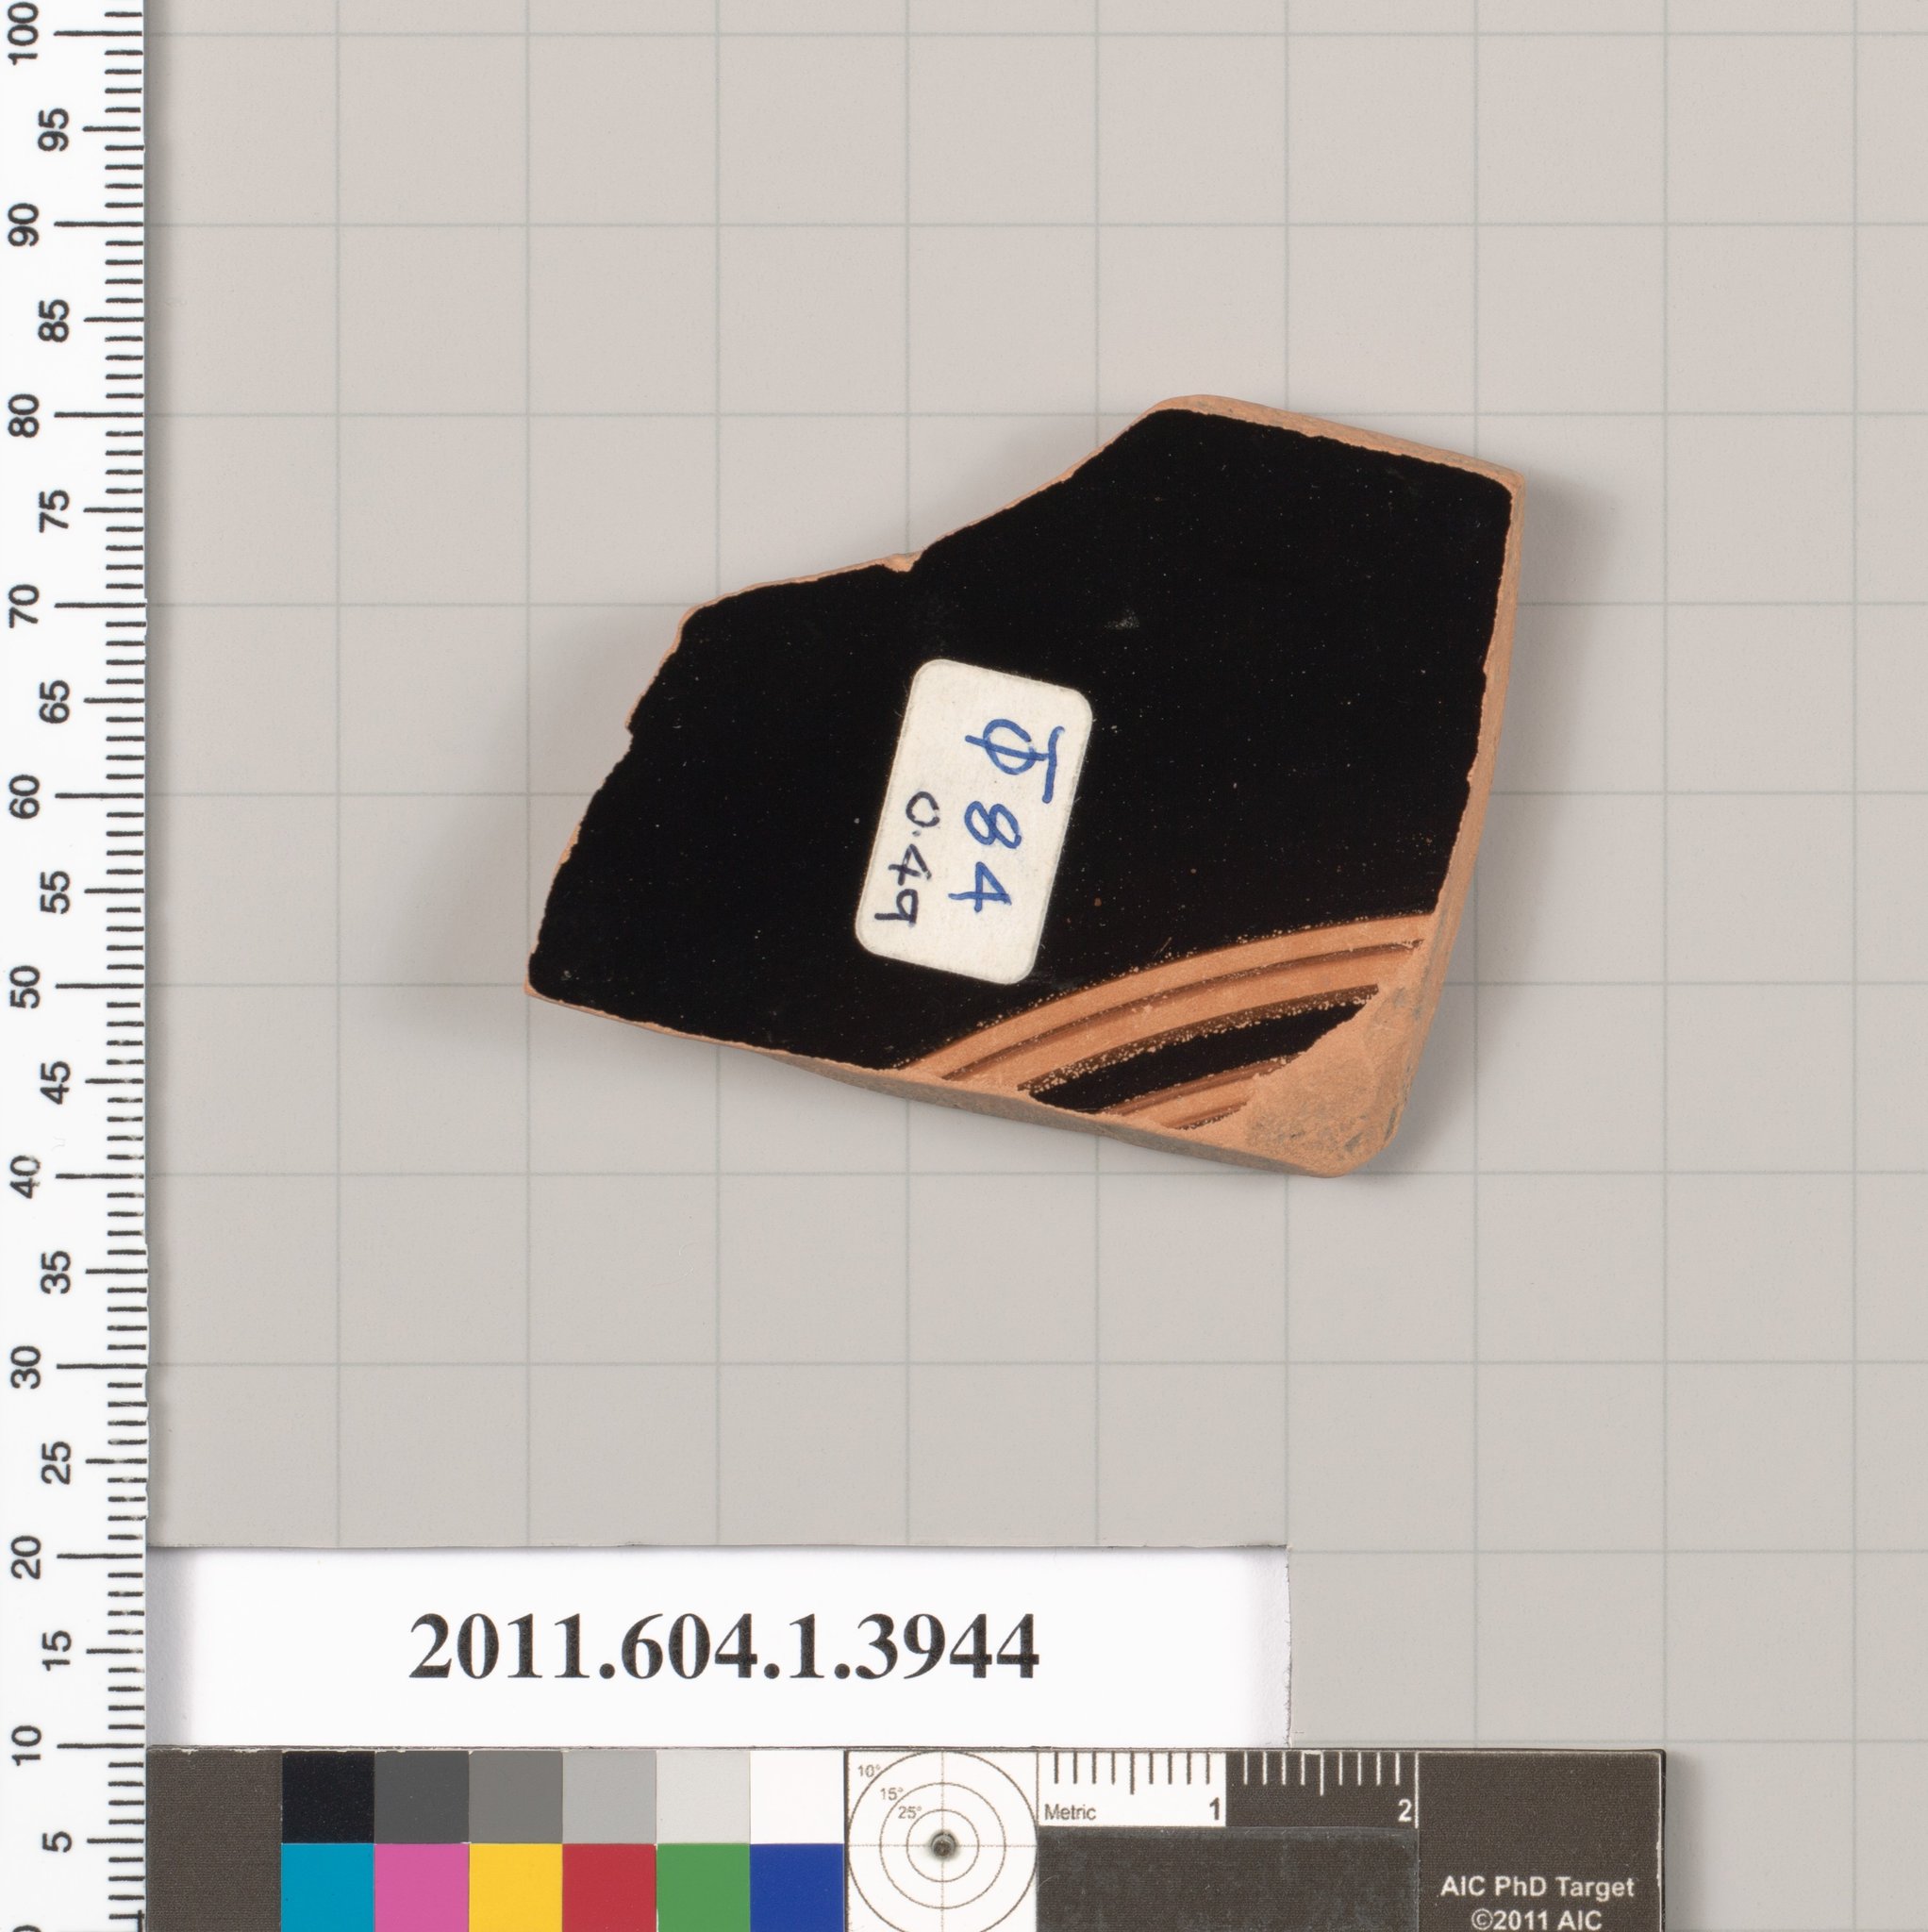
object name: kylix fragment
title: Terracotta fragment of a kylix (drinking cup)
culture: greek, attic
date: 500-476 BCE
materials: terracotta